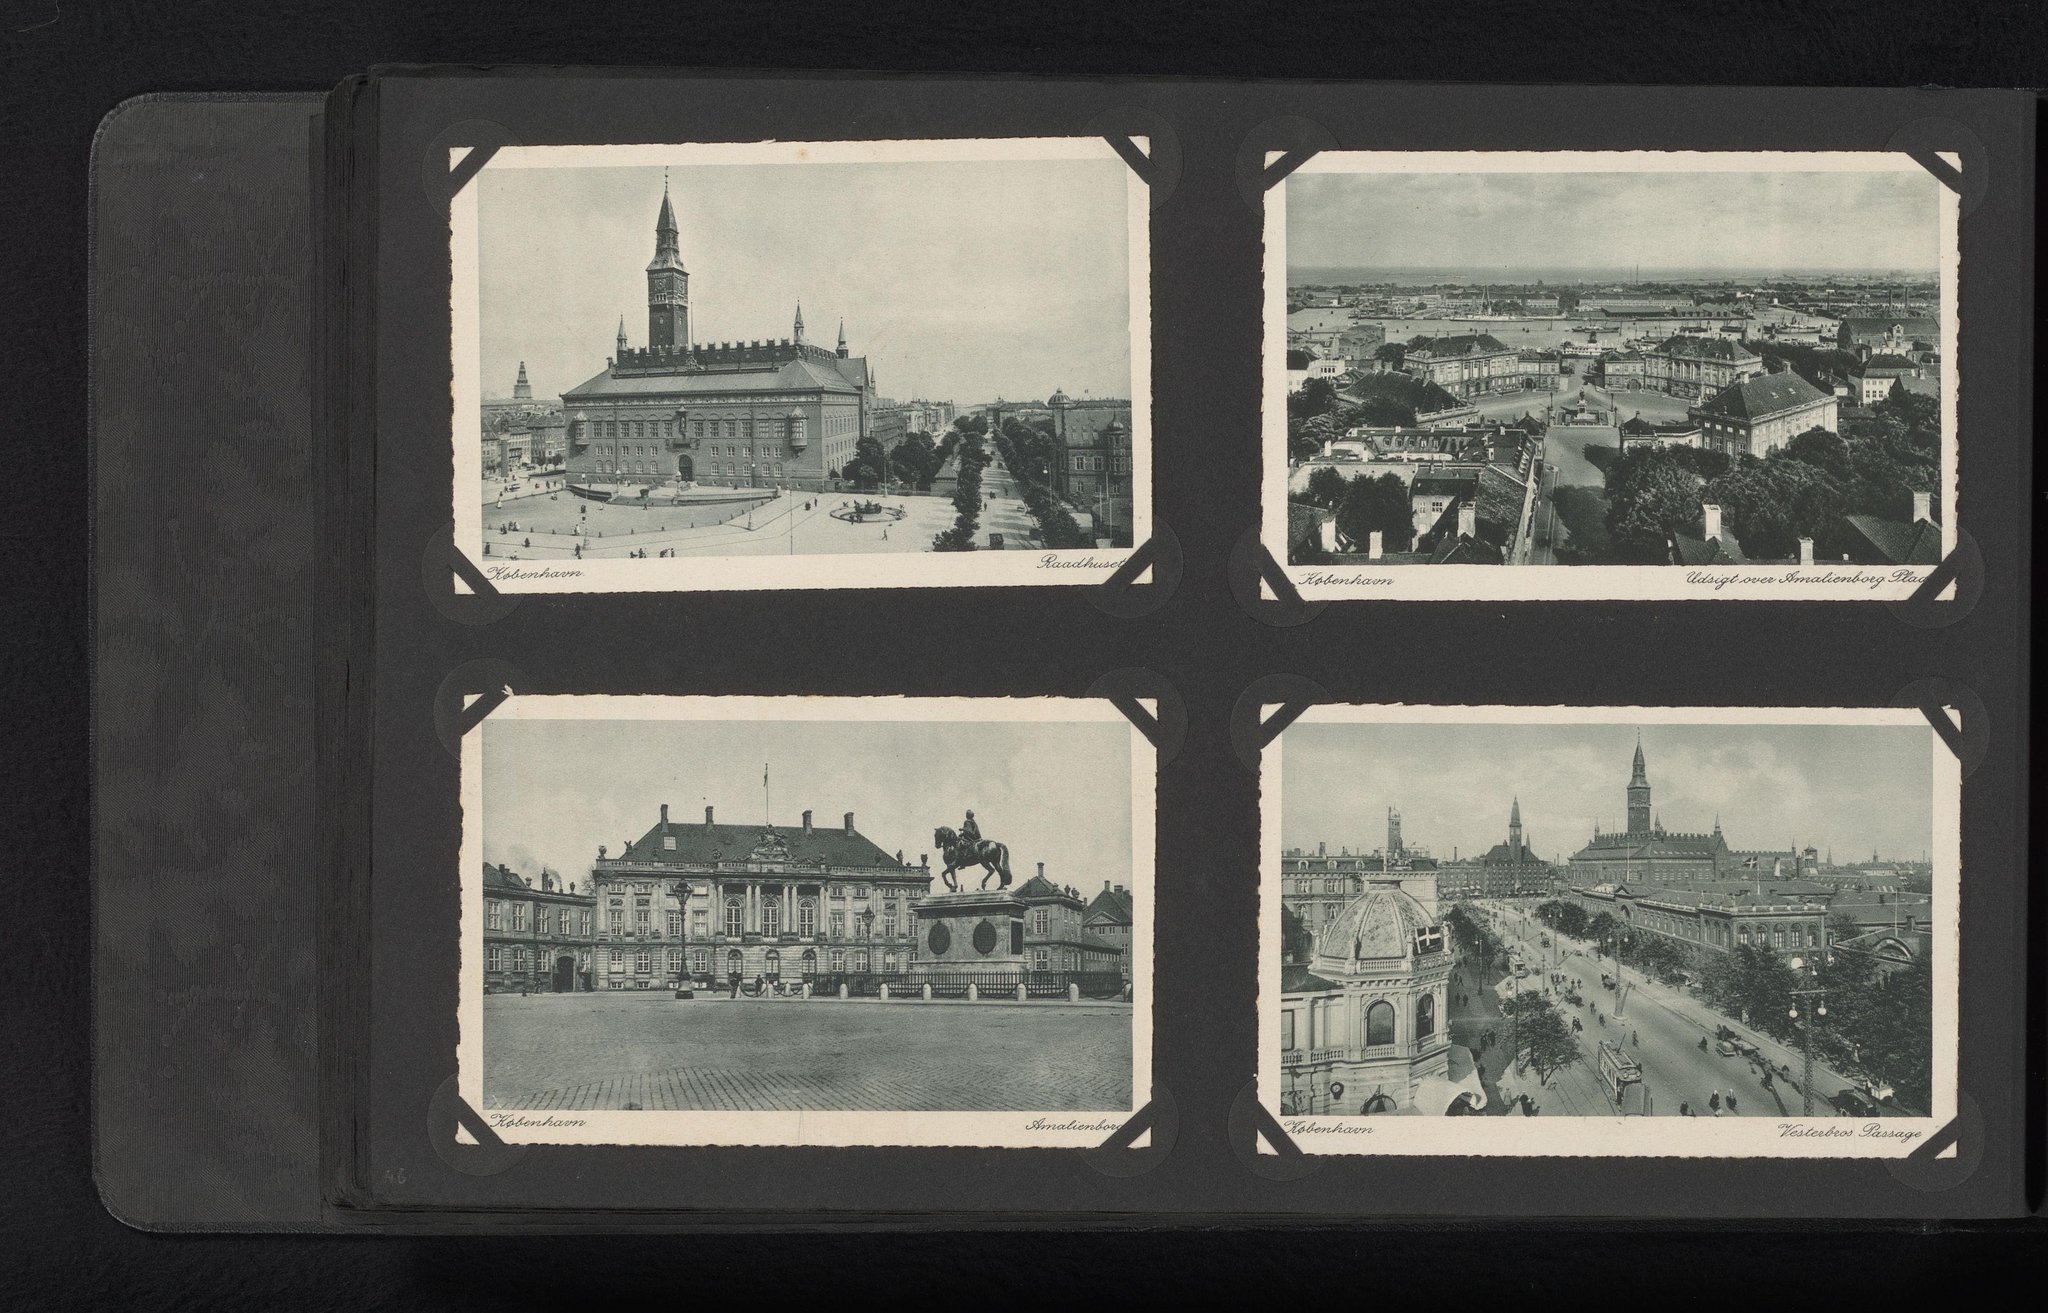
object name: album leaf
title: Vier fotomechanische prentbriefkaarten van Kopenhagen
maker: Anonymous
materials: cardboard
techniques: rotogravure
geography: copenhagen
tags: square, place, circus, etc., city-view in general; 'veduta', avenue, boulevard, promenade, esplanade, copenhagen (city)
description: Deze prenten maken deel uit van een album.